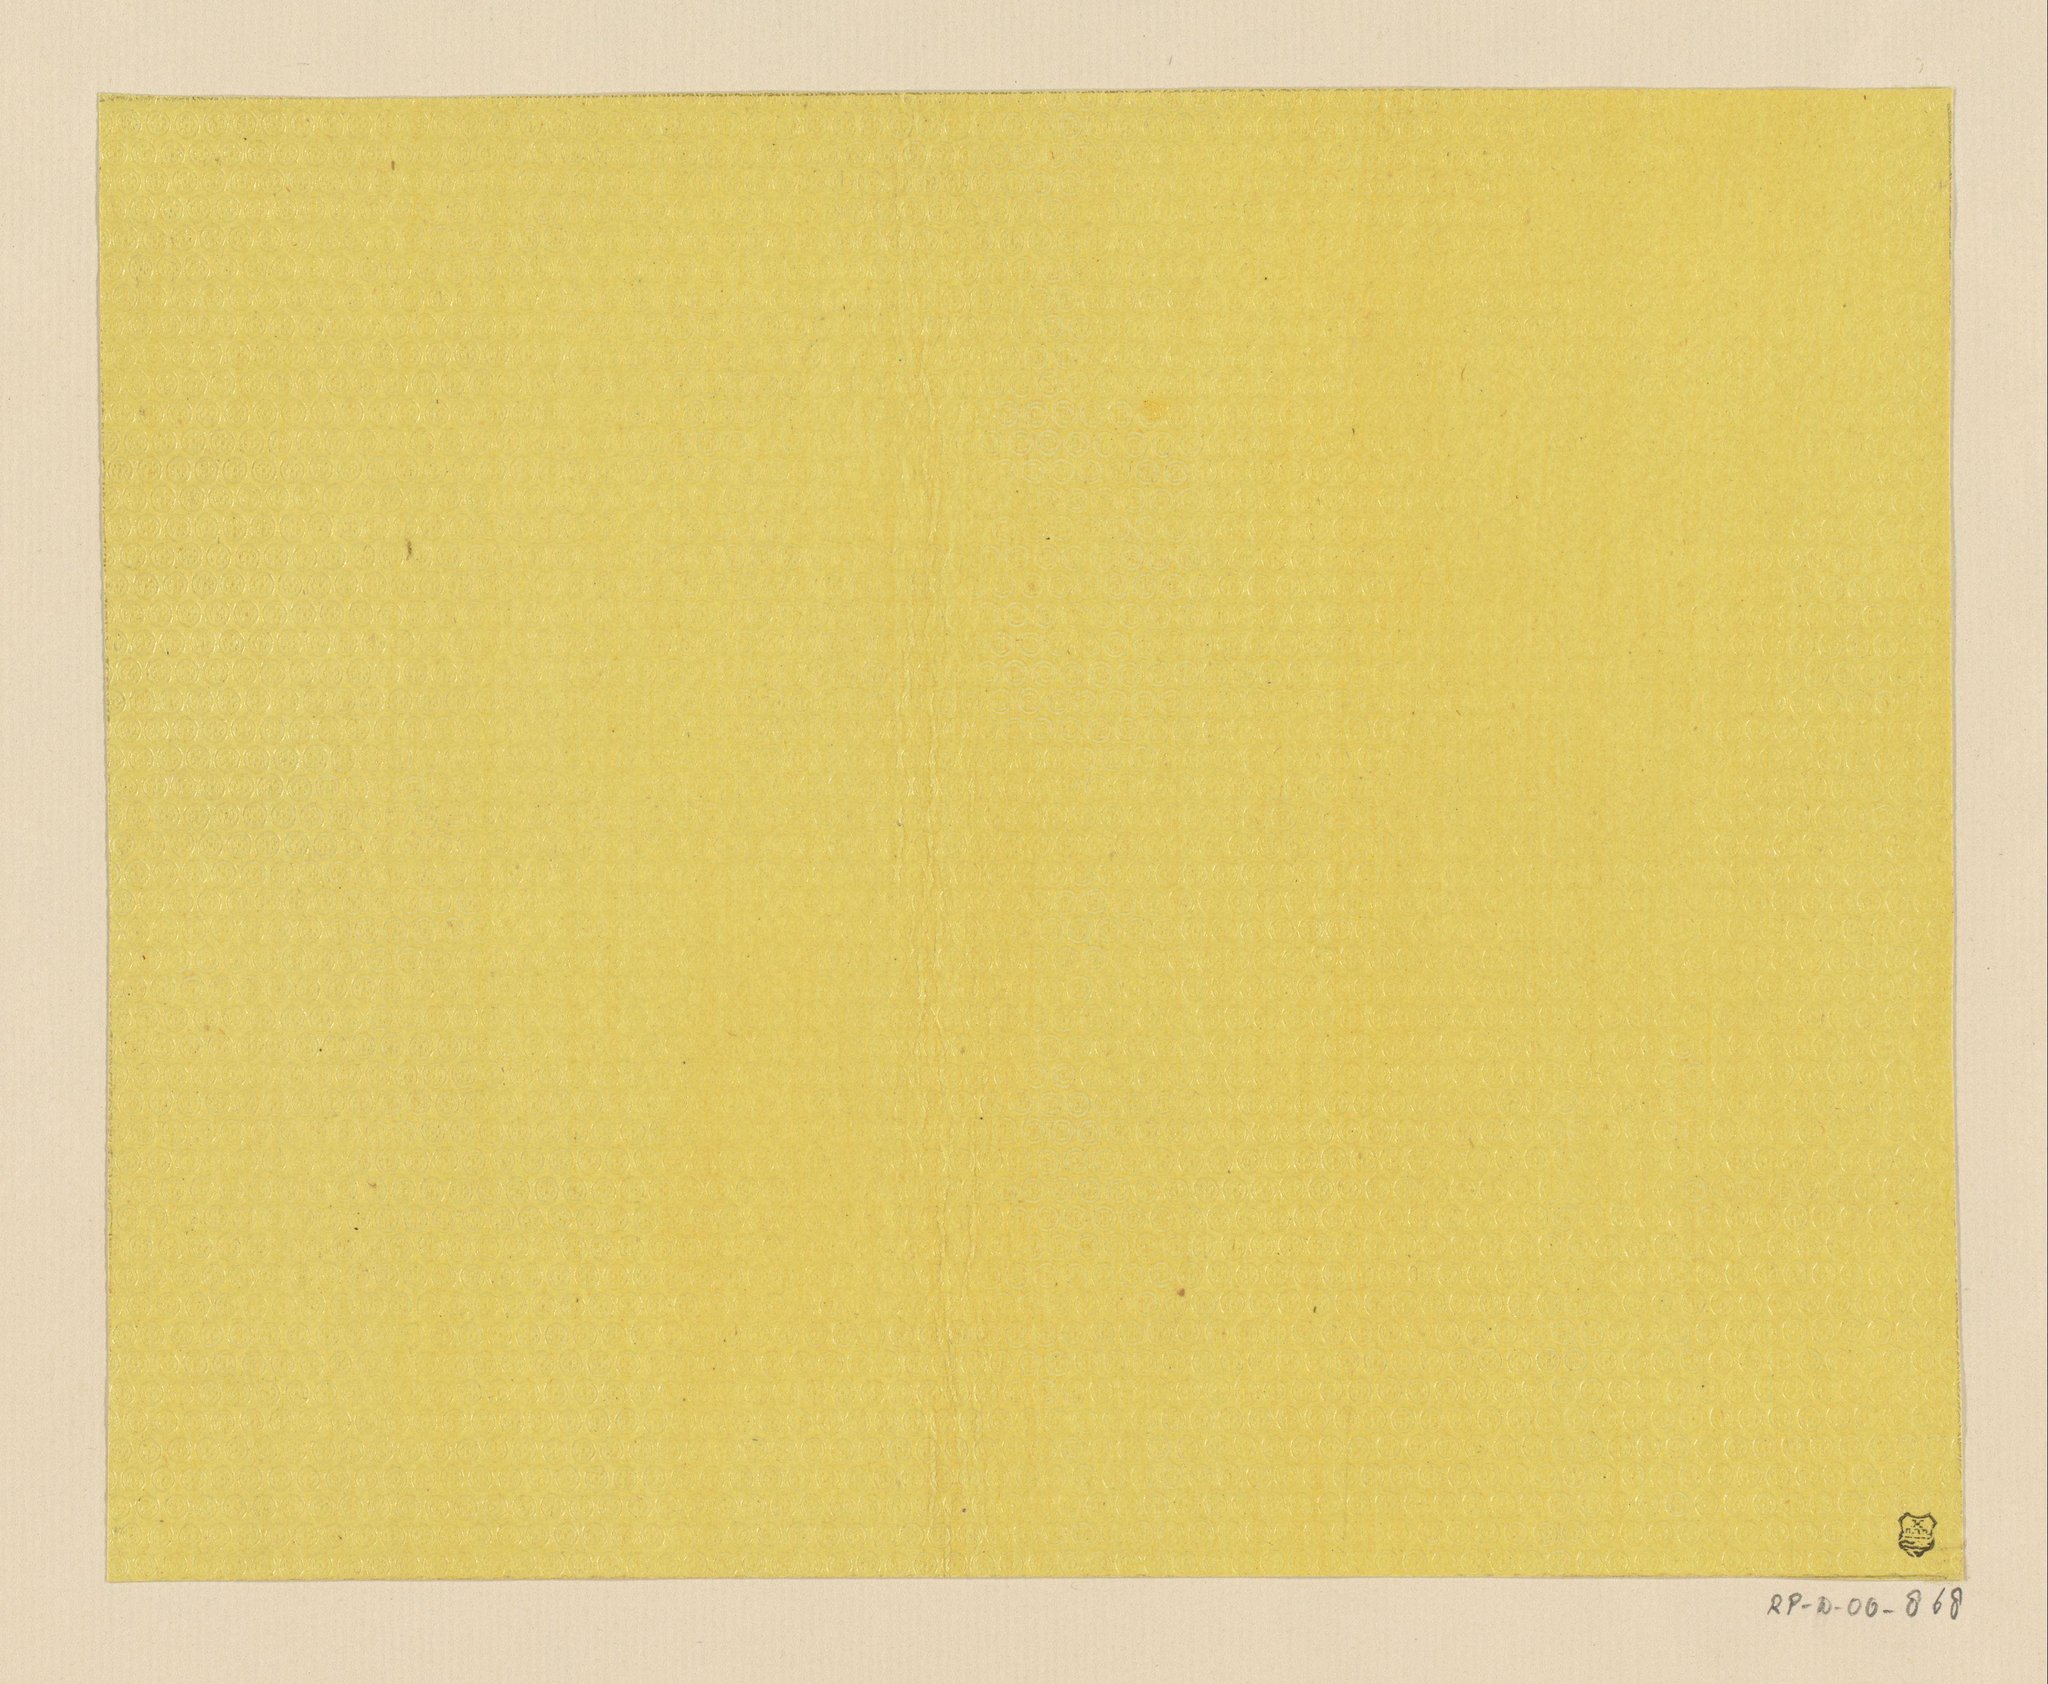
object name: embossed paper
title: Blad met gegaufreerd strooipatroon van cirkels met rozet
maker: Anonymous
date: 1800-1900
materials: lacquer, paint, paper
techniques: machining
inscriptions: collector's mark: Lugt 2760